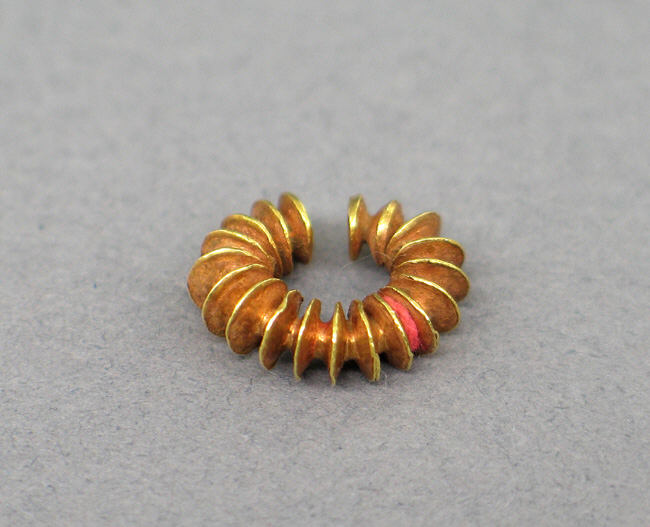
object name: ear clip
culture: indonesian, javanese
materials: gold